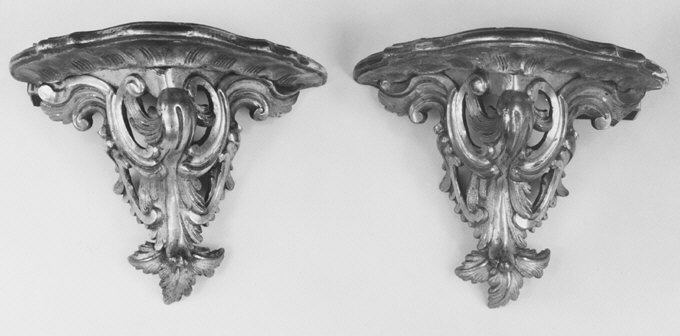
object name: wall bracket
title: Pair of wall brackets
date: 1730-1740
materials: gilt bronze, wood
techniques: carving, gilding